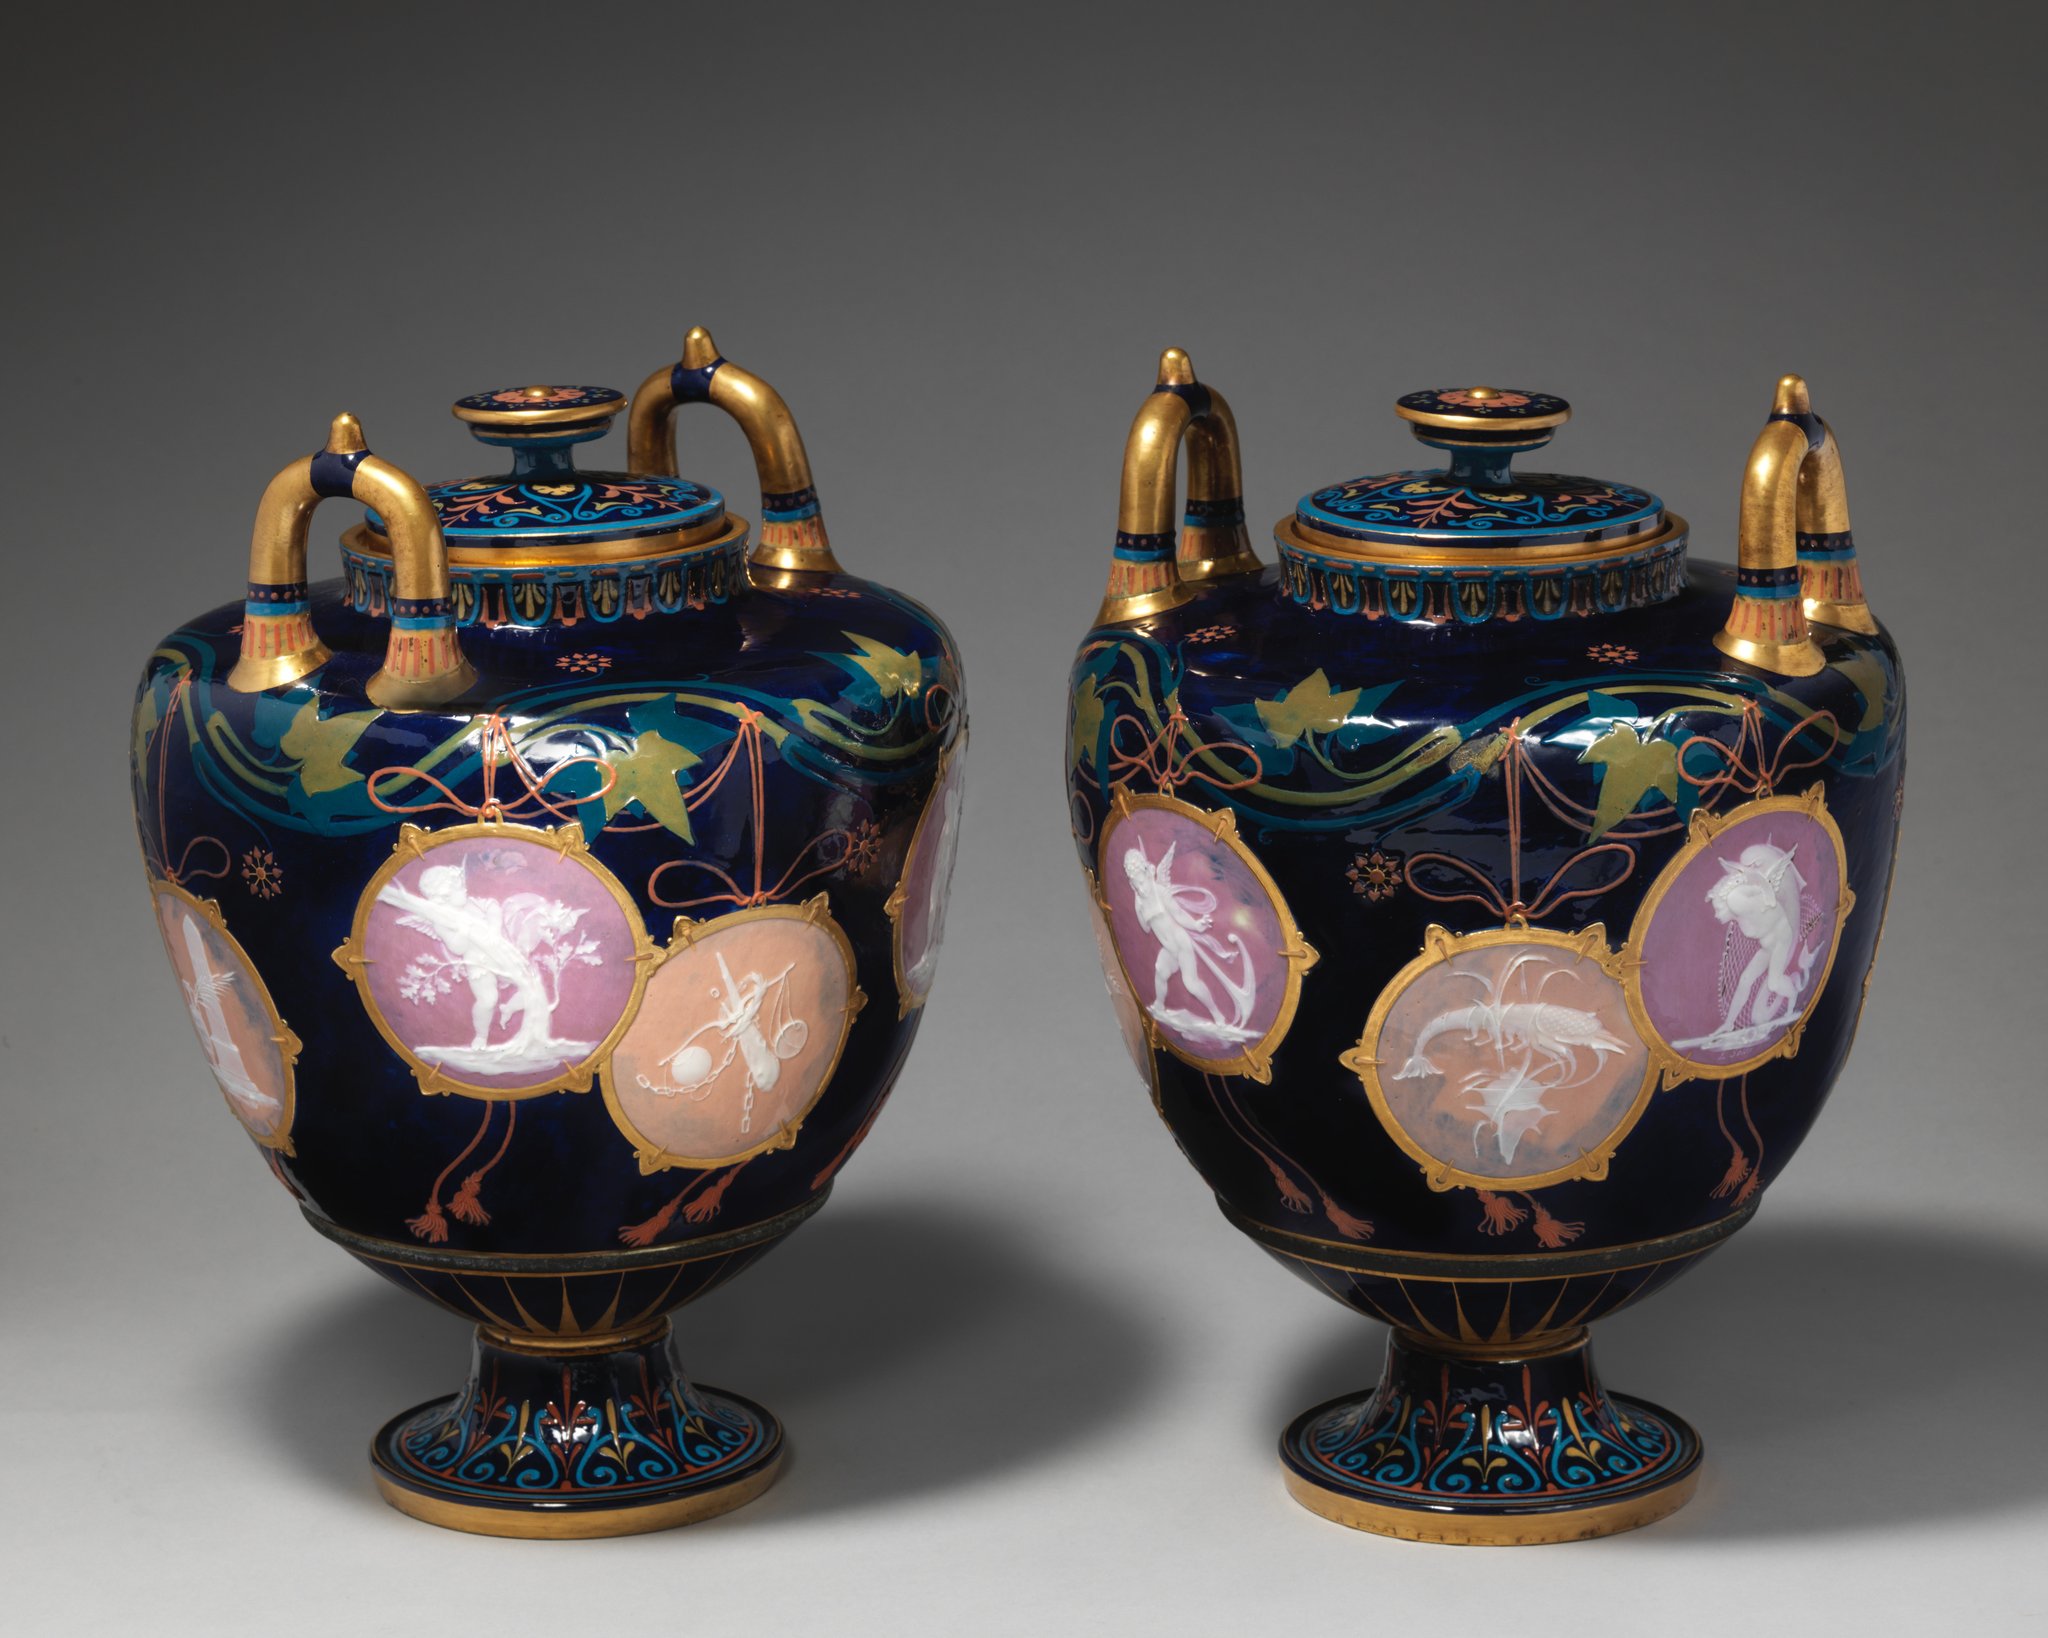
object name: vase pair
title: Pair of "Pompeian" vases with covers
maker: minton(s)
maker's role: maker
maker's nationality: british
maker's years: 1793-2001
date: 1874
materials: enamel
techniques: gilding